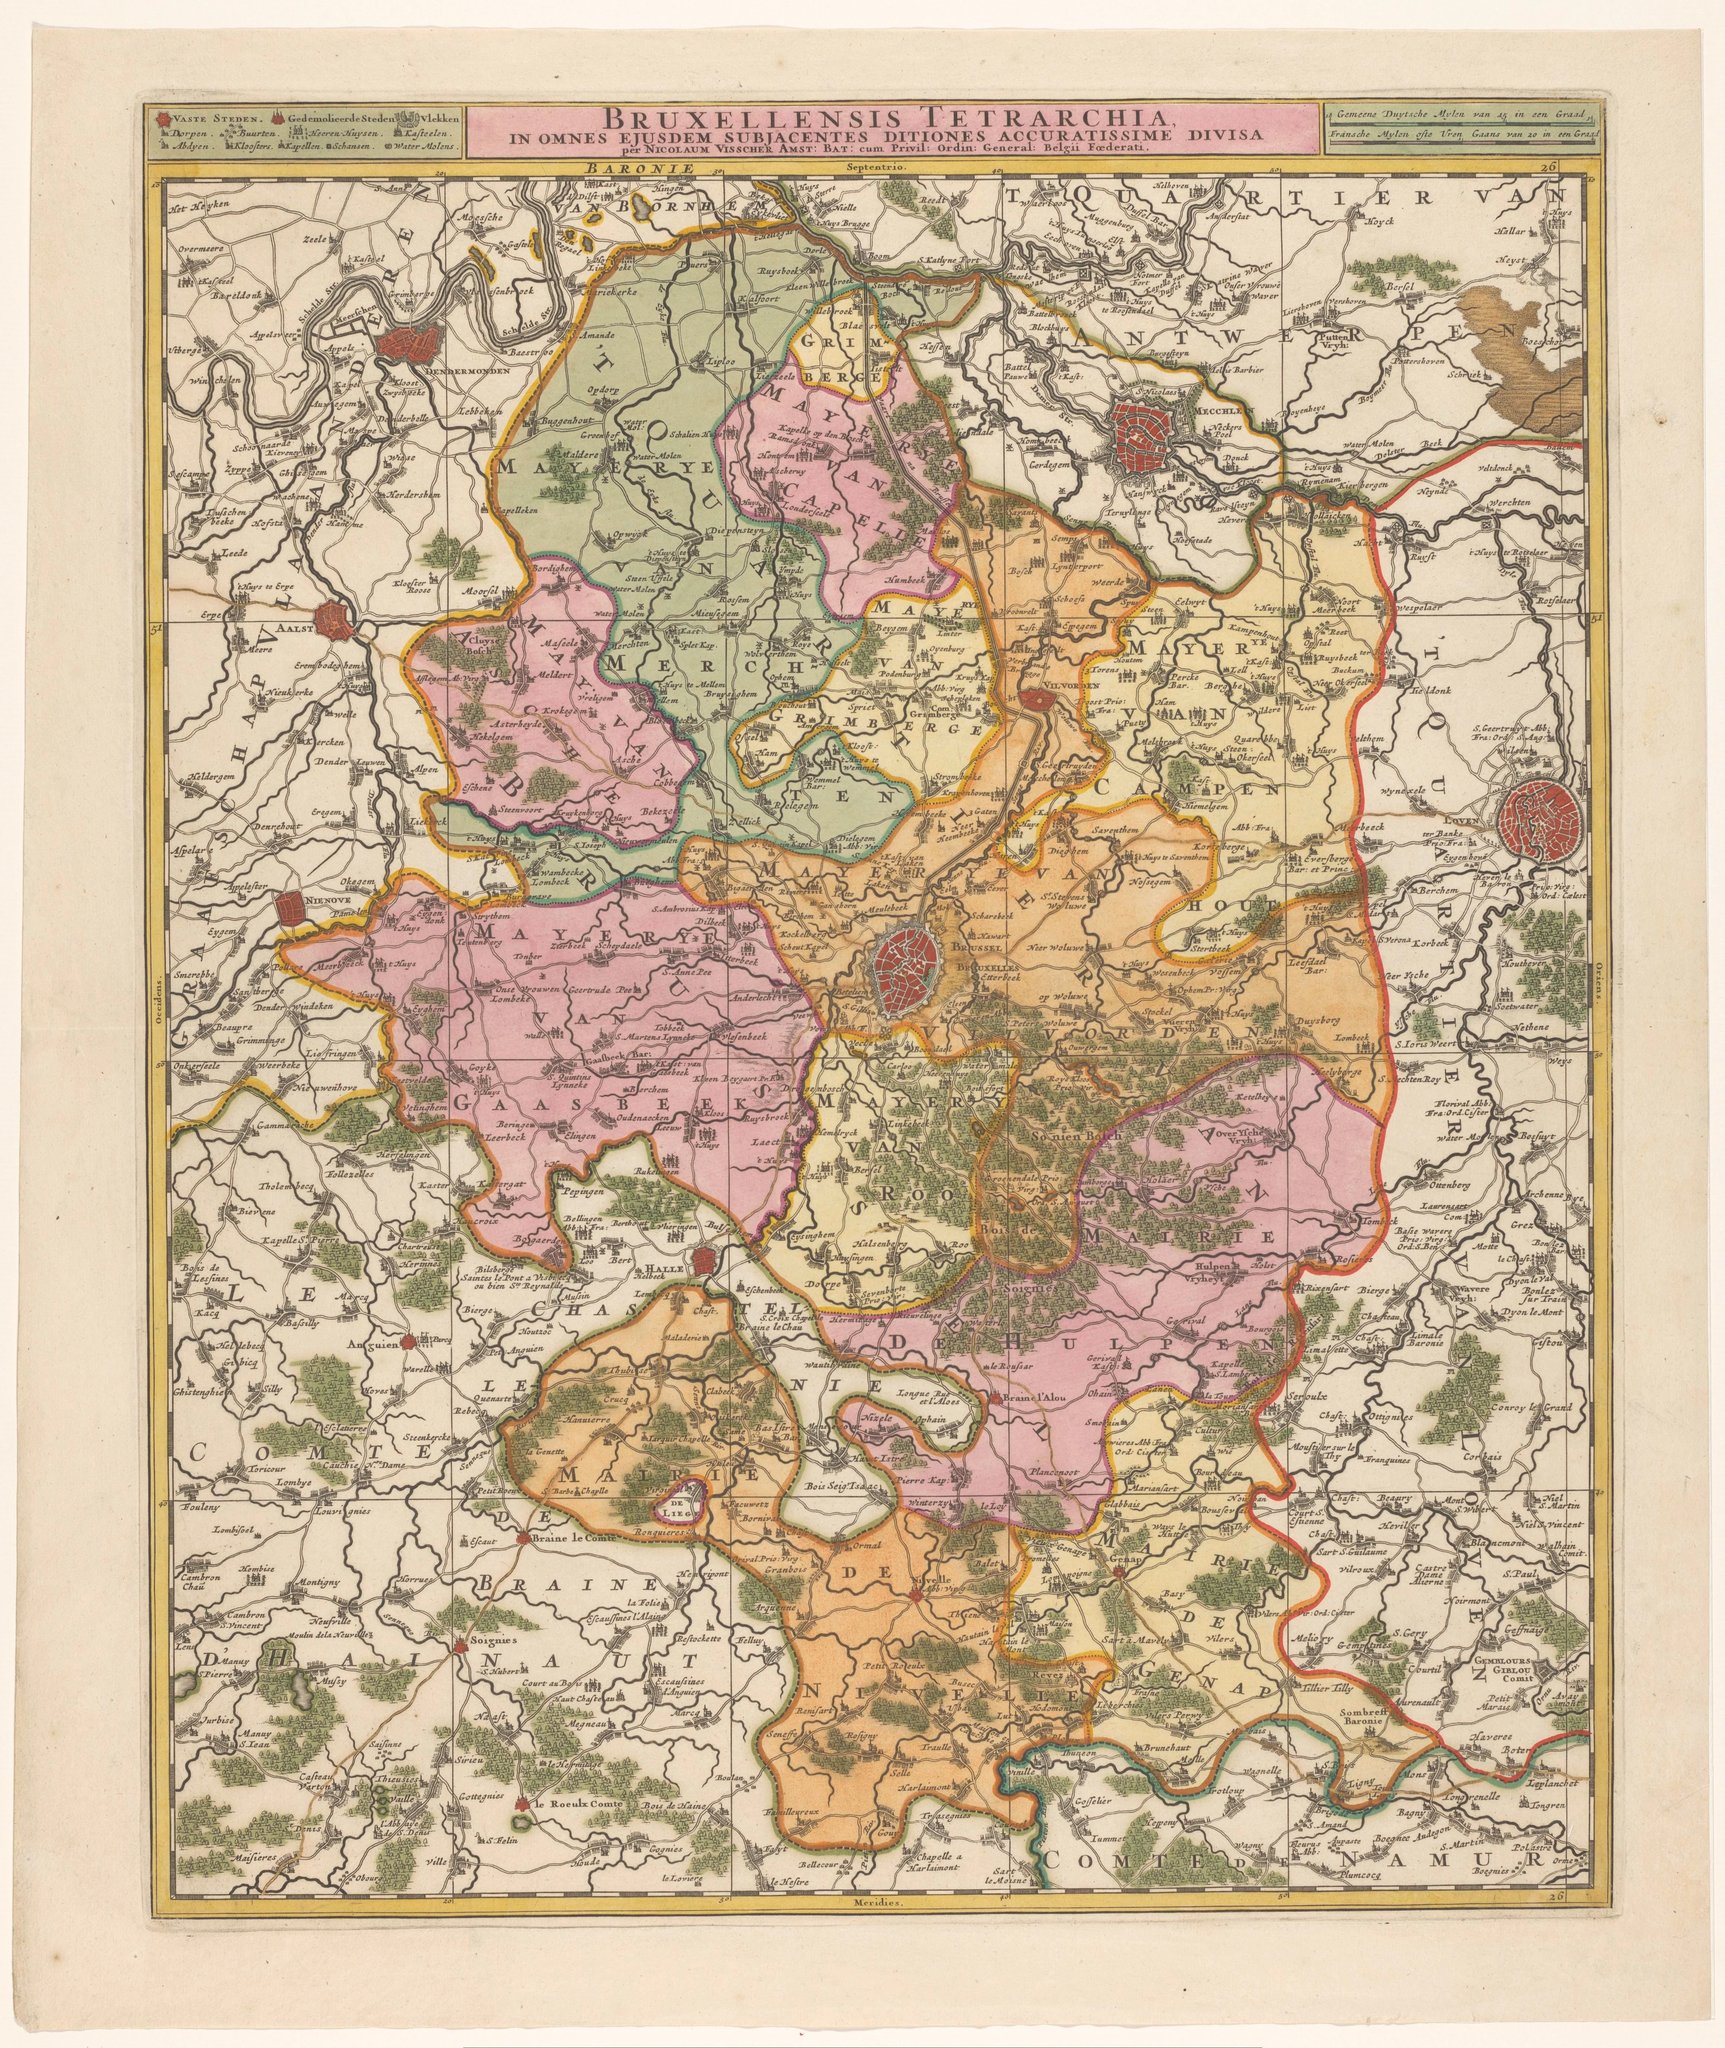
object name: map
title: Bruxellensis tetrarchia in omnes ejusdem subjacentes ditiones accuratissime divisa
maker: Anonymous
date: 1677-1720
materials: paper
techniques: engraving, etching, hand coloring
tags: maps of separate countries or regions, brabant, brussels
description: Kaart van het kwartier van Brussel, één van de vier kwartieren waarin het hertogdom Brabant is verdeeld. In een balk boven de kaart, in het midden, de titel. Links hiervan een legenda. Rechts van de titel twee schaalstokken: 1 1/2 Gemeene Duytsche Mijlen van 15 in een Graad / 2 Fransche Mylen ofte Uren Gaans van 20 in een Graad. De kaart is voorzien van een coördinaten-net en een gradenverdeling.